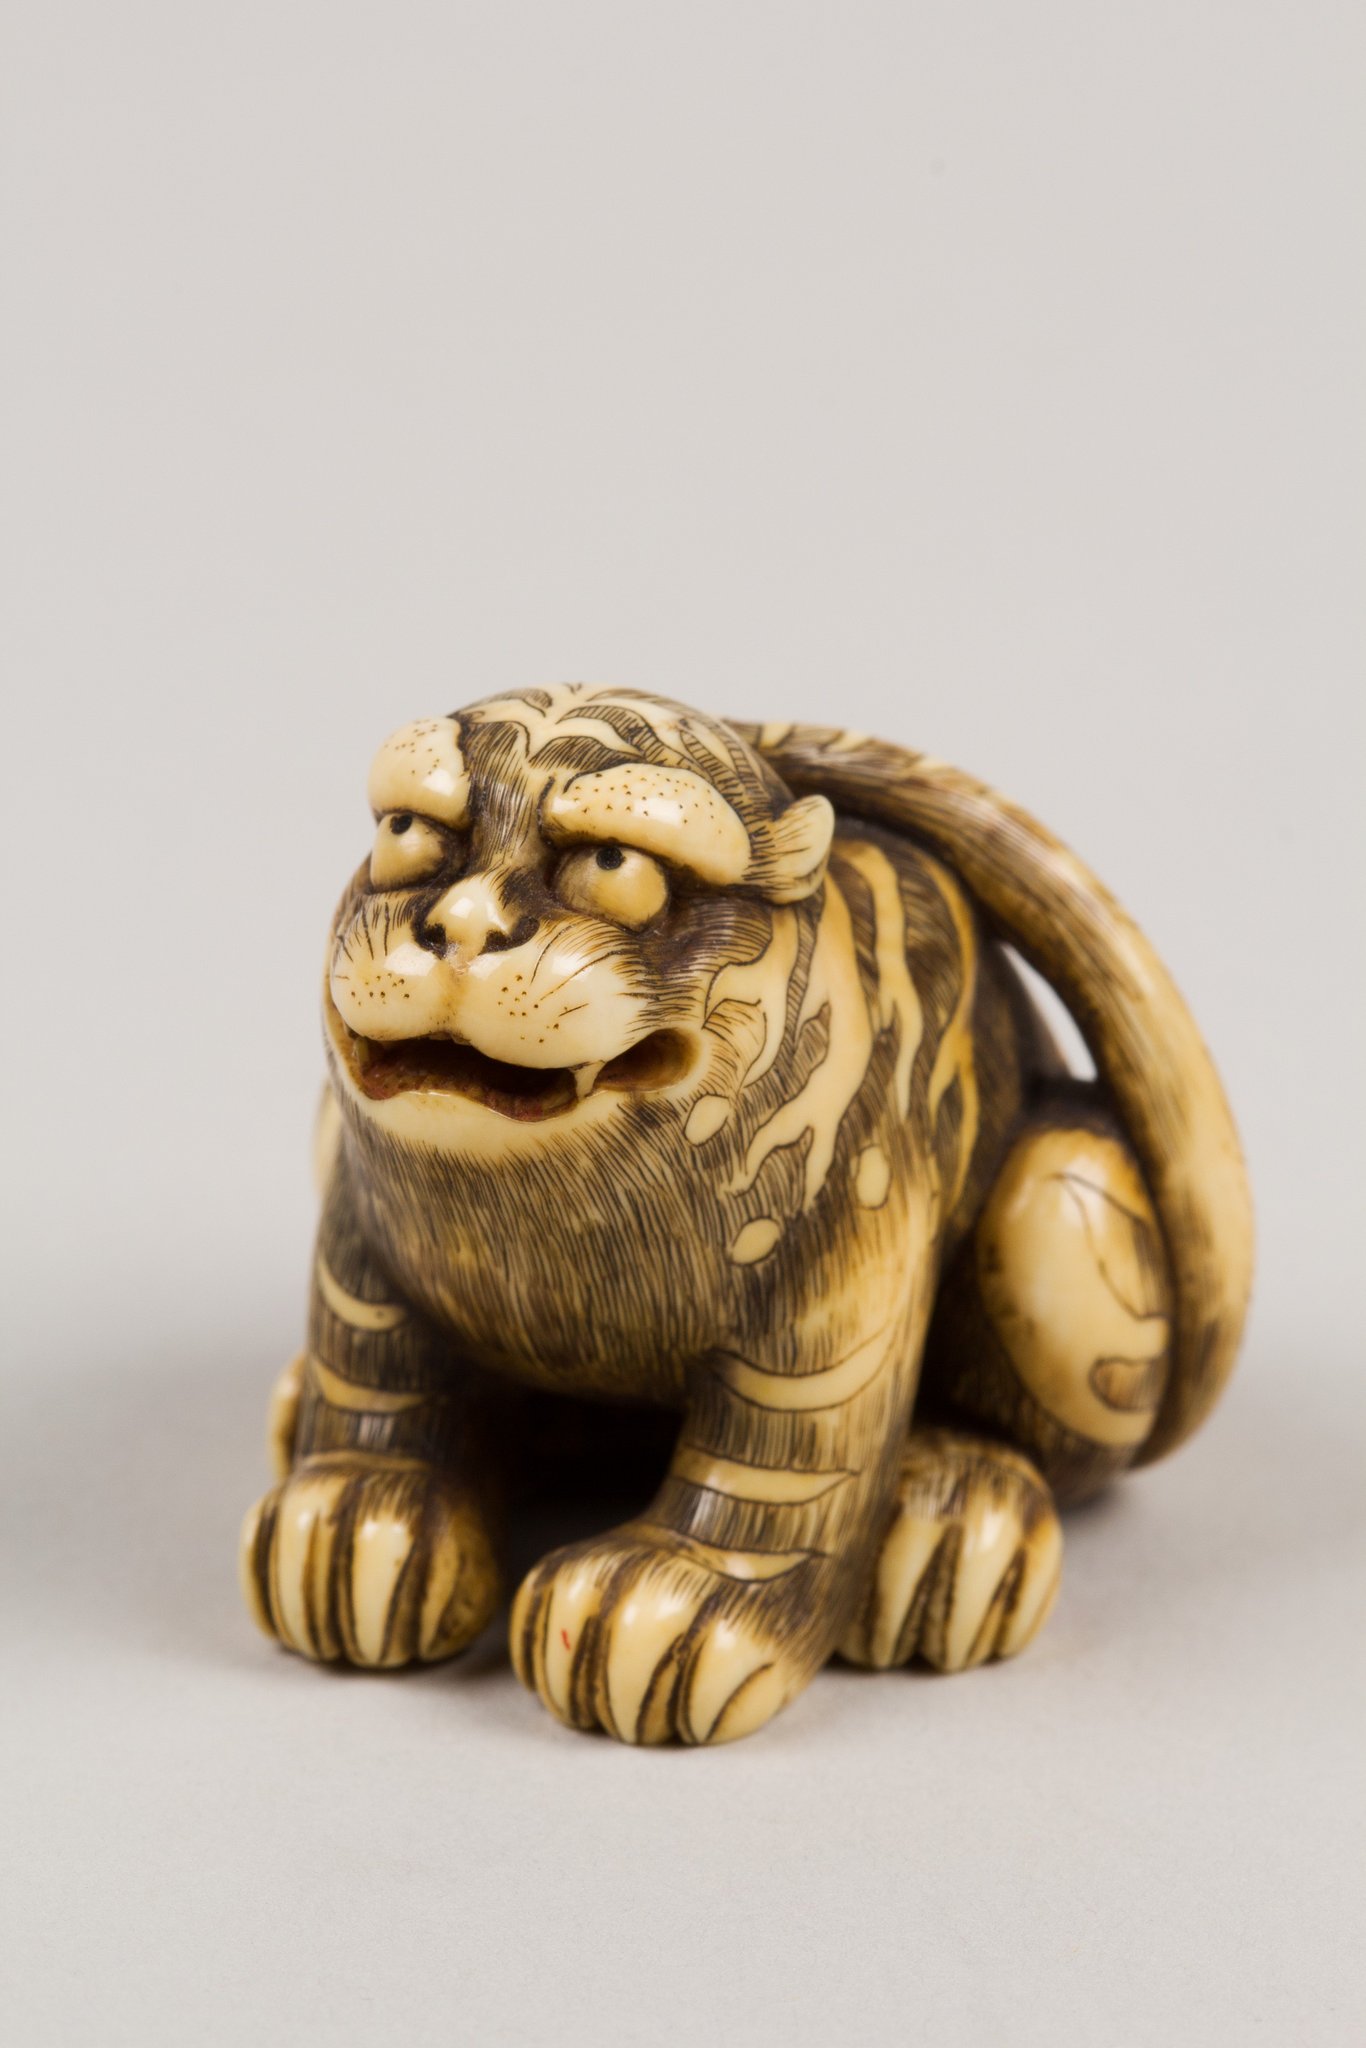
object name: netsuke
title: Netsuke of Seated Tiger, Tail Resting on his Back;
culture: japanese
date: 1615-1868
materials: ivory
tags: tigers